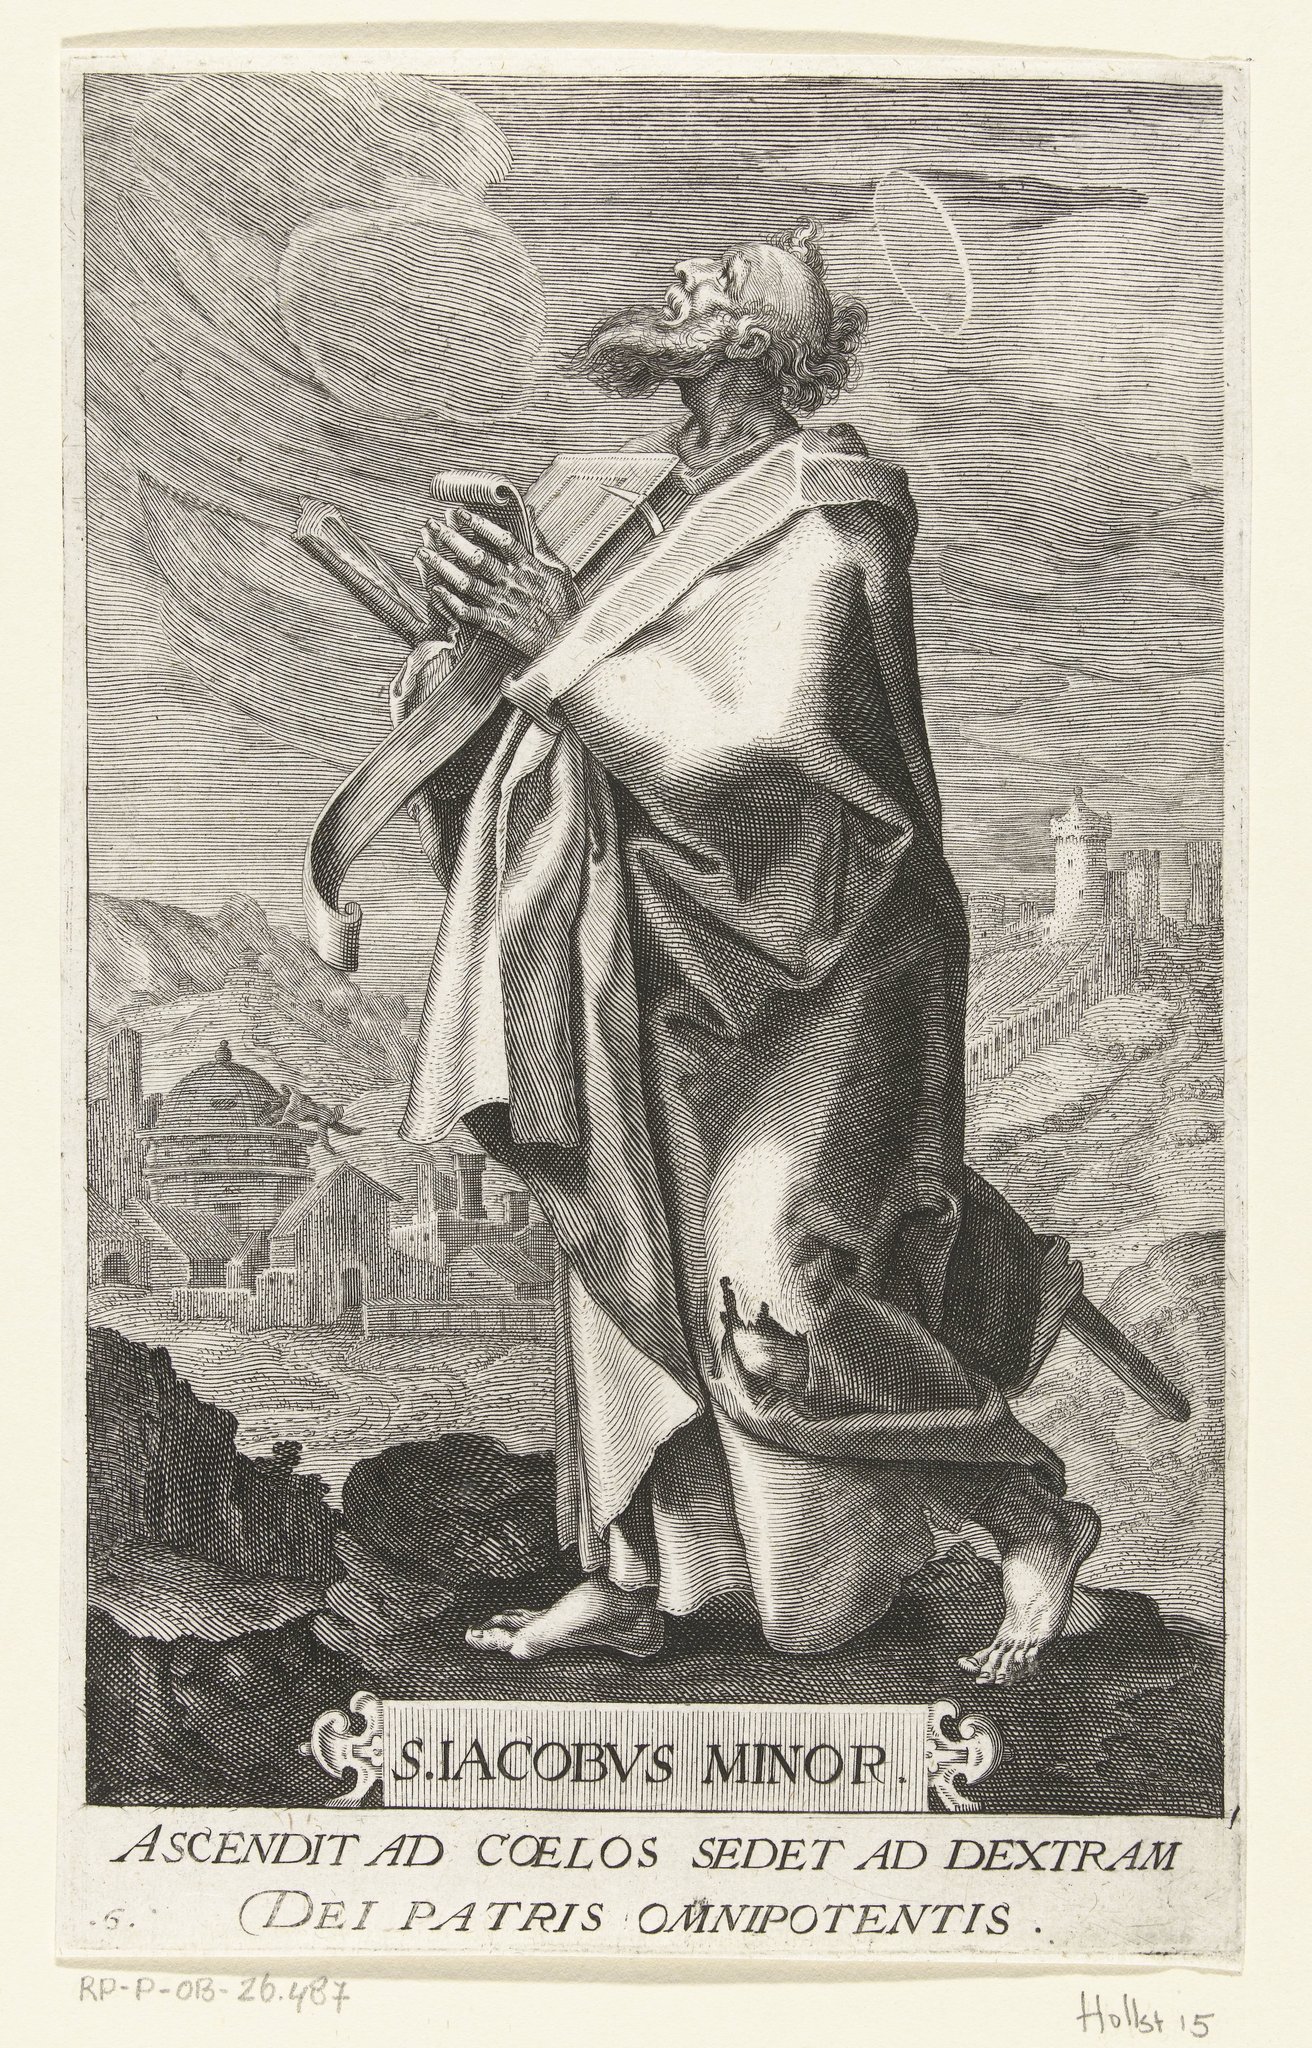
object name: print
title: Apostel Jakobus de Mindere (Jacobus Minor)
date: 1591-1629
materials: paper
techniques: engraving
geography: prague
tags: the apostle james the less, first bishop of jerusalem; possible attributes: book, fuller's club, scroll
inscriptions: collector's mark: Lugt 2228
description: Apostel Jakobus de Mindere (Jacobus Minor) met boek, schriftrol en staf. Op de achtergrond een scène uit zijn leven, de heilige sterft de marteldood bij een val van het dak van de tempel. Onder de voorstelling staat een Latijnse regel uit de apostolische geloofsbelijdenis.